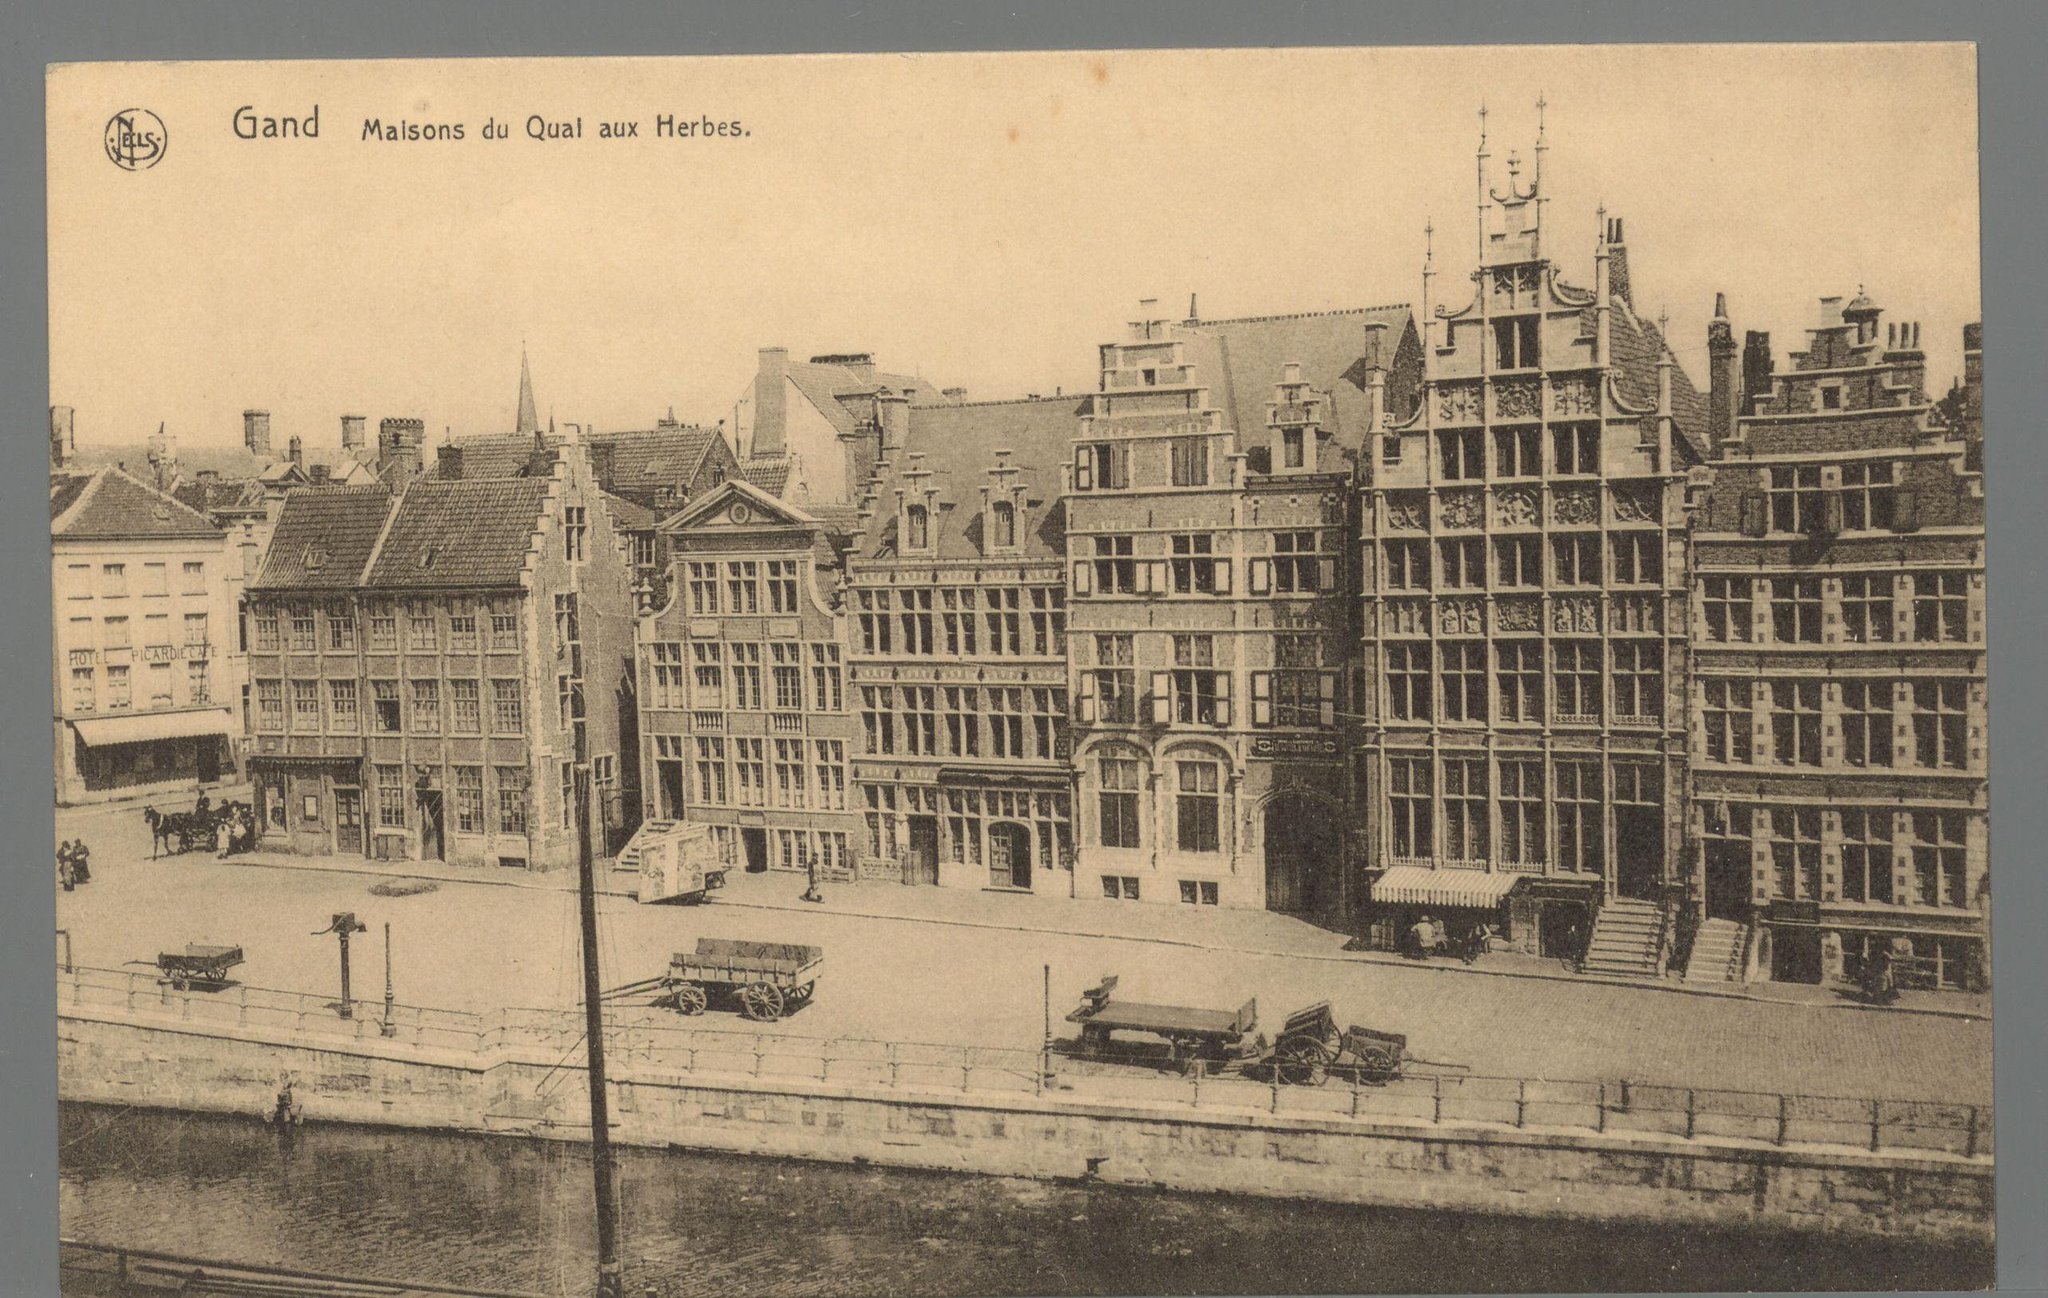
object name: photomechanical print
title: Série 3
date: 1913-1930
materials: cardboard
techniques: photograph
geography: ghent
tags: urban housing, city-view, and landscape with man-made constructions (+ city(-scape) with figures, staffage), quay, ghent